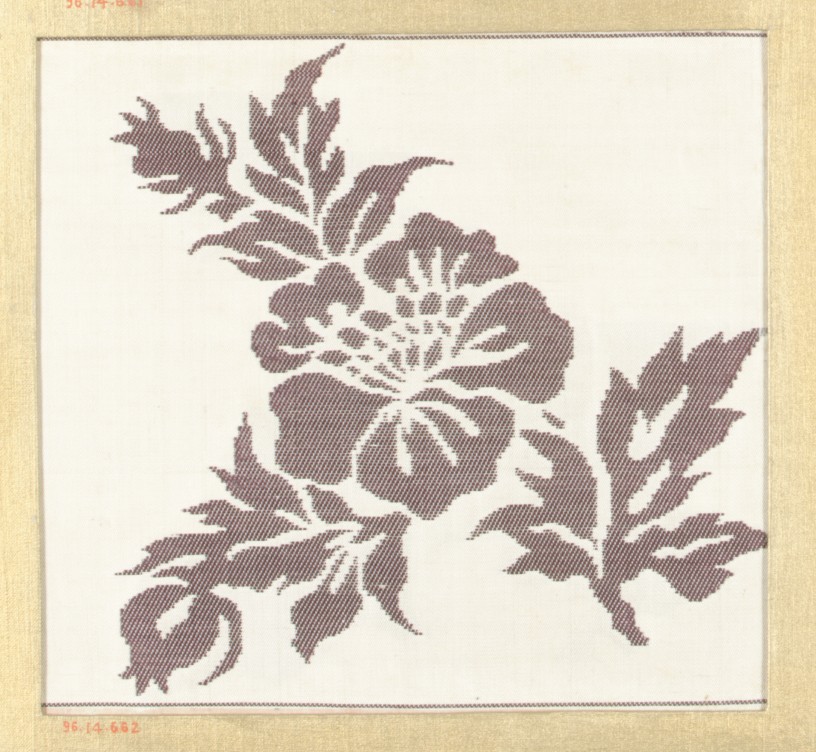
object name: piece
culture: japanese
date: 1701-1900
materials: silk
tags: leaves